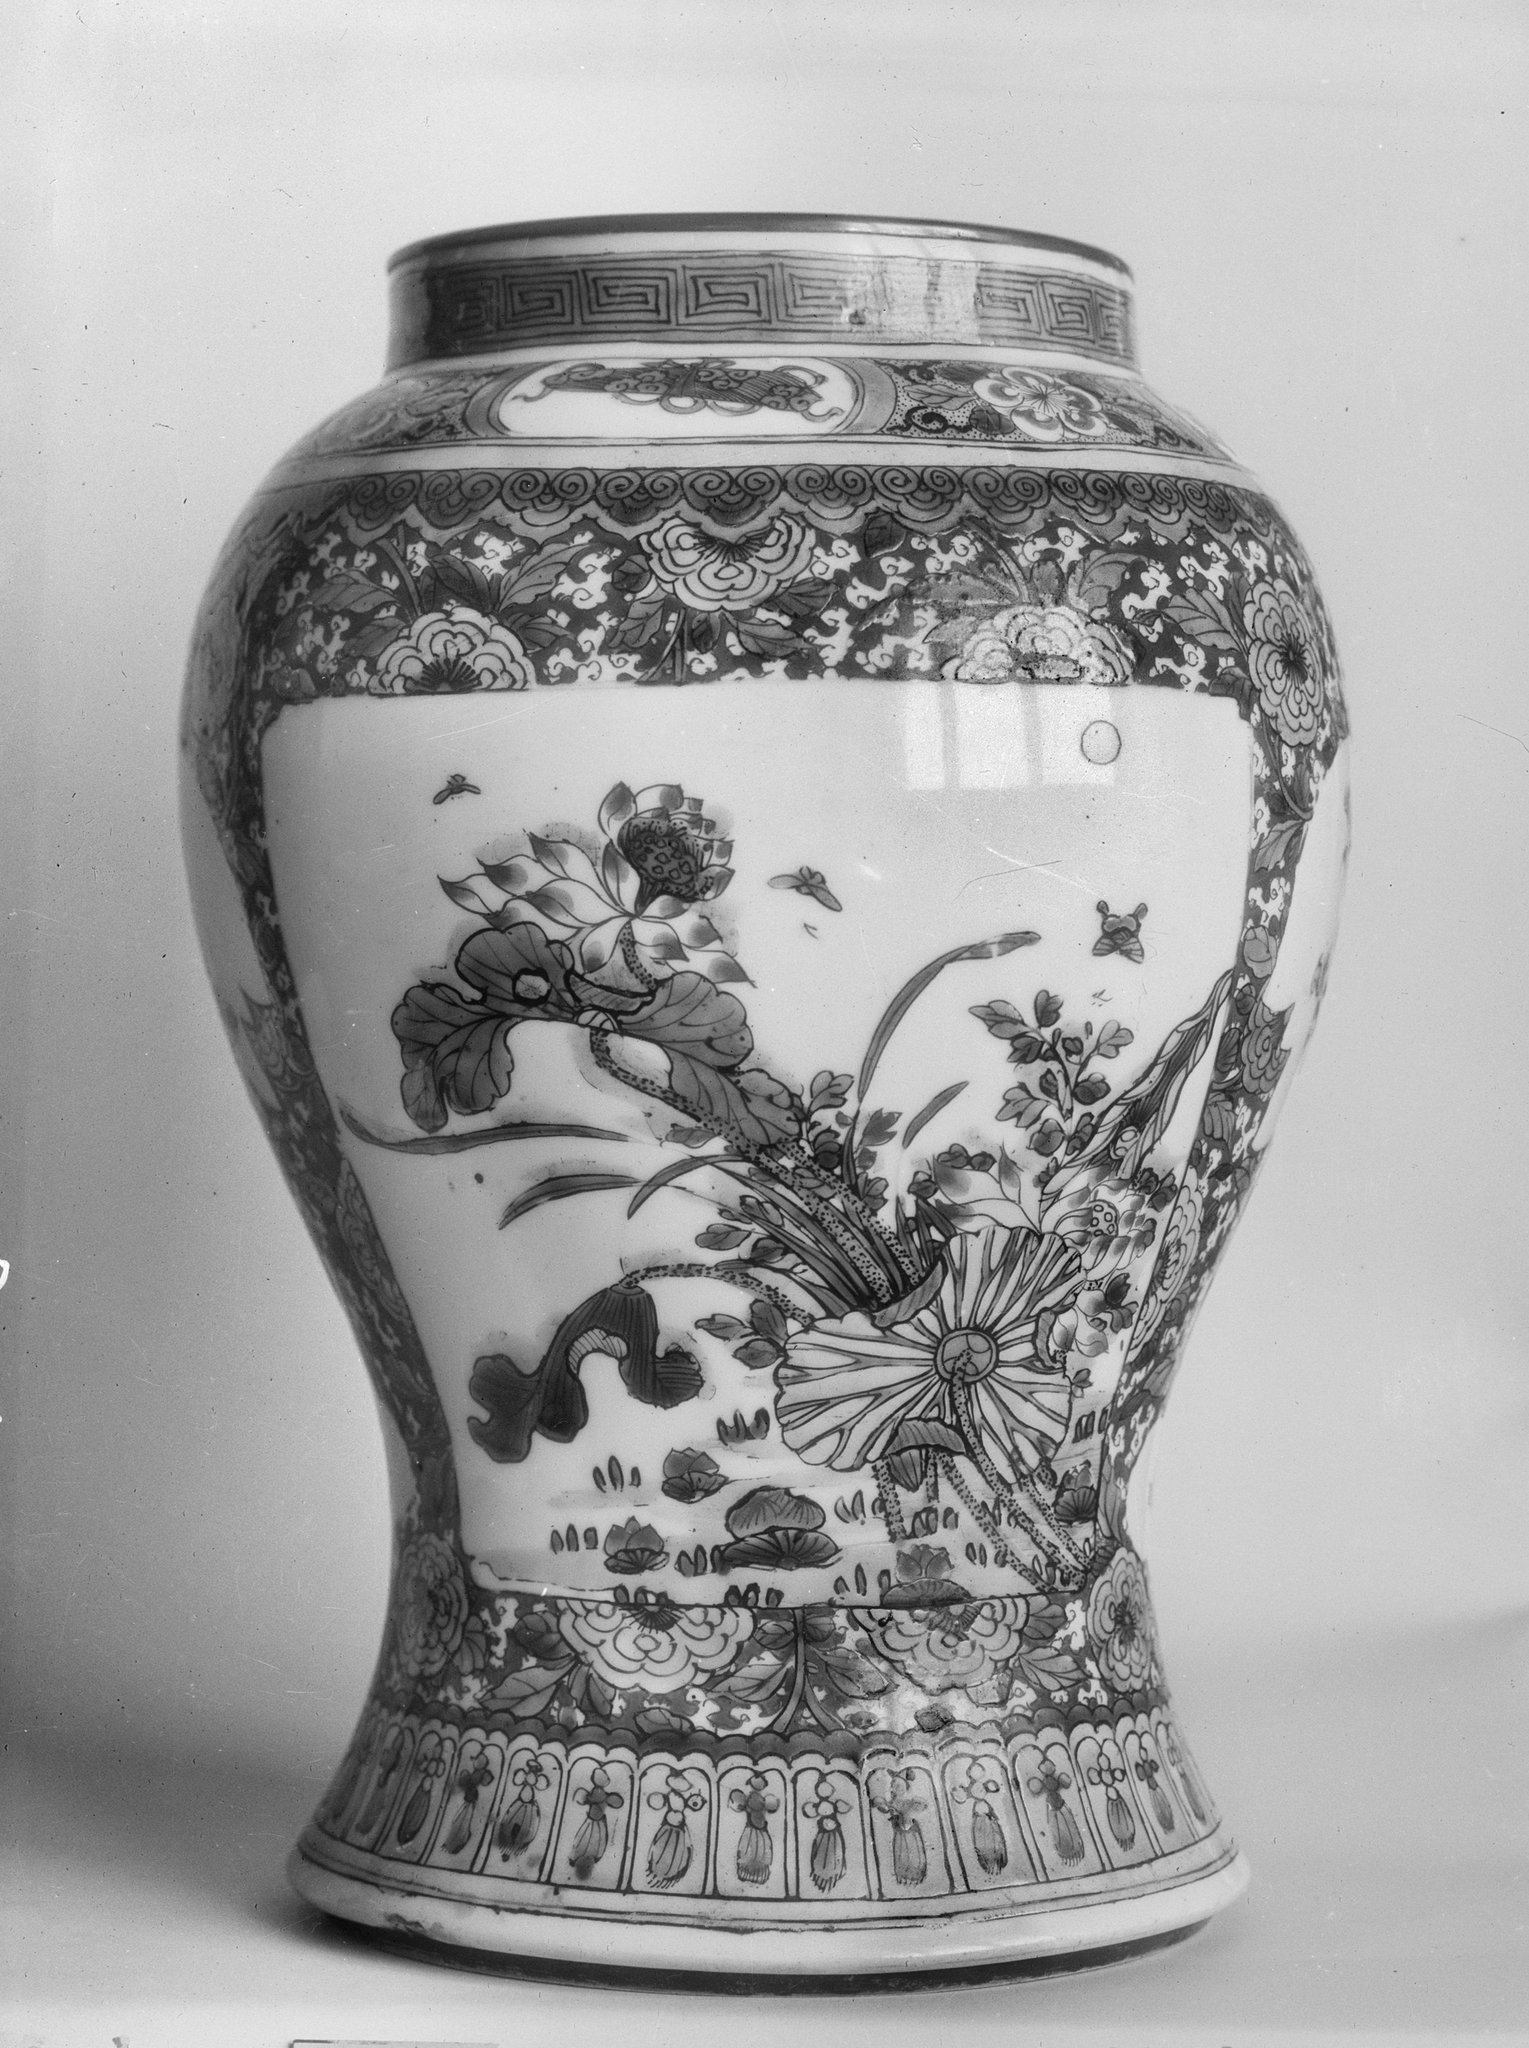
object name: vase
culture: chinese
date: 1662-1722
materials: porcelain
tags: flowers,leaves